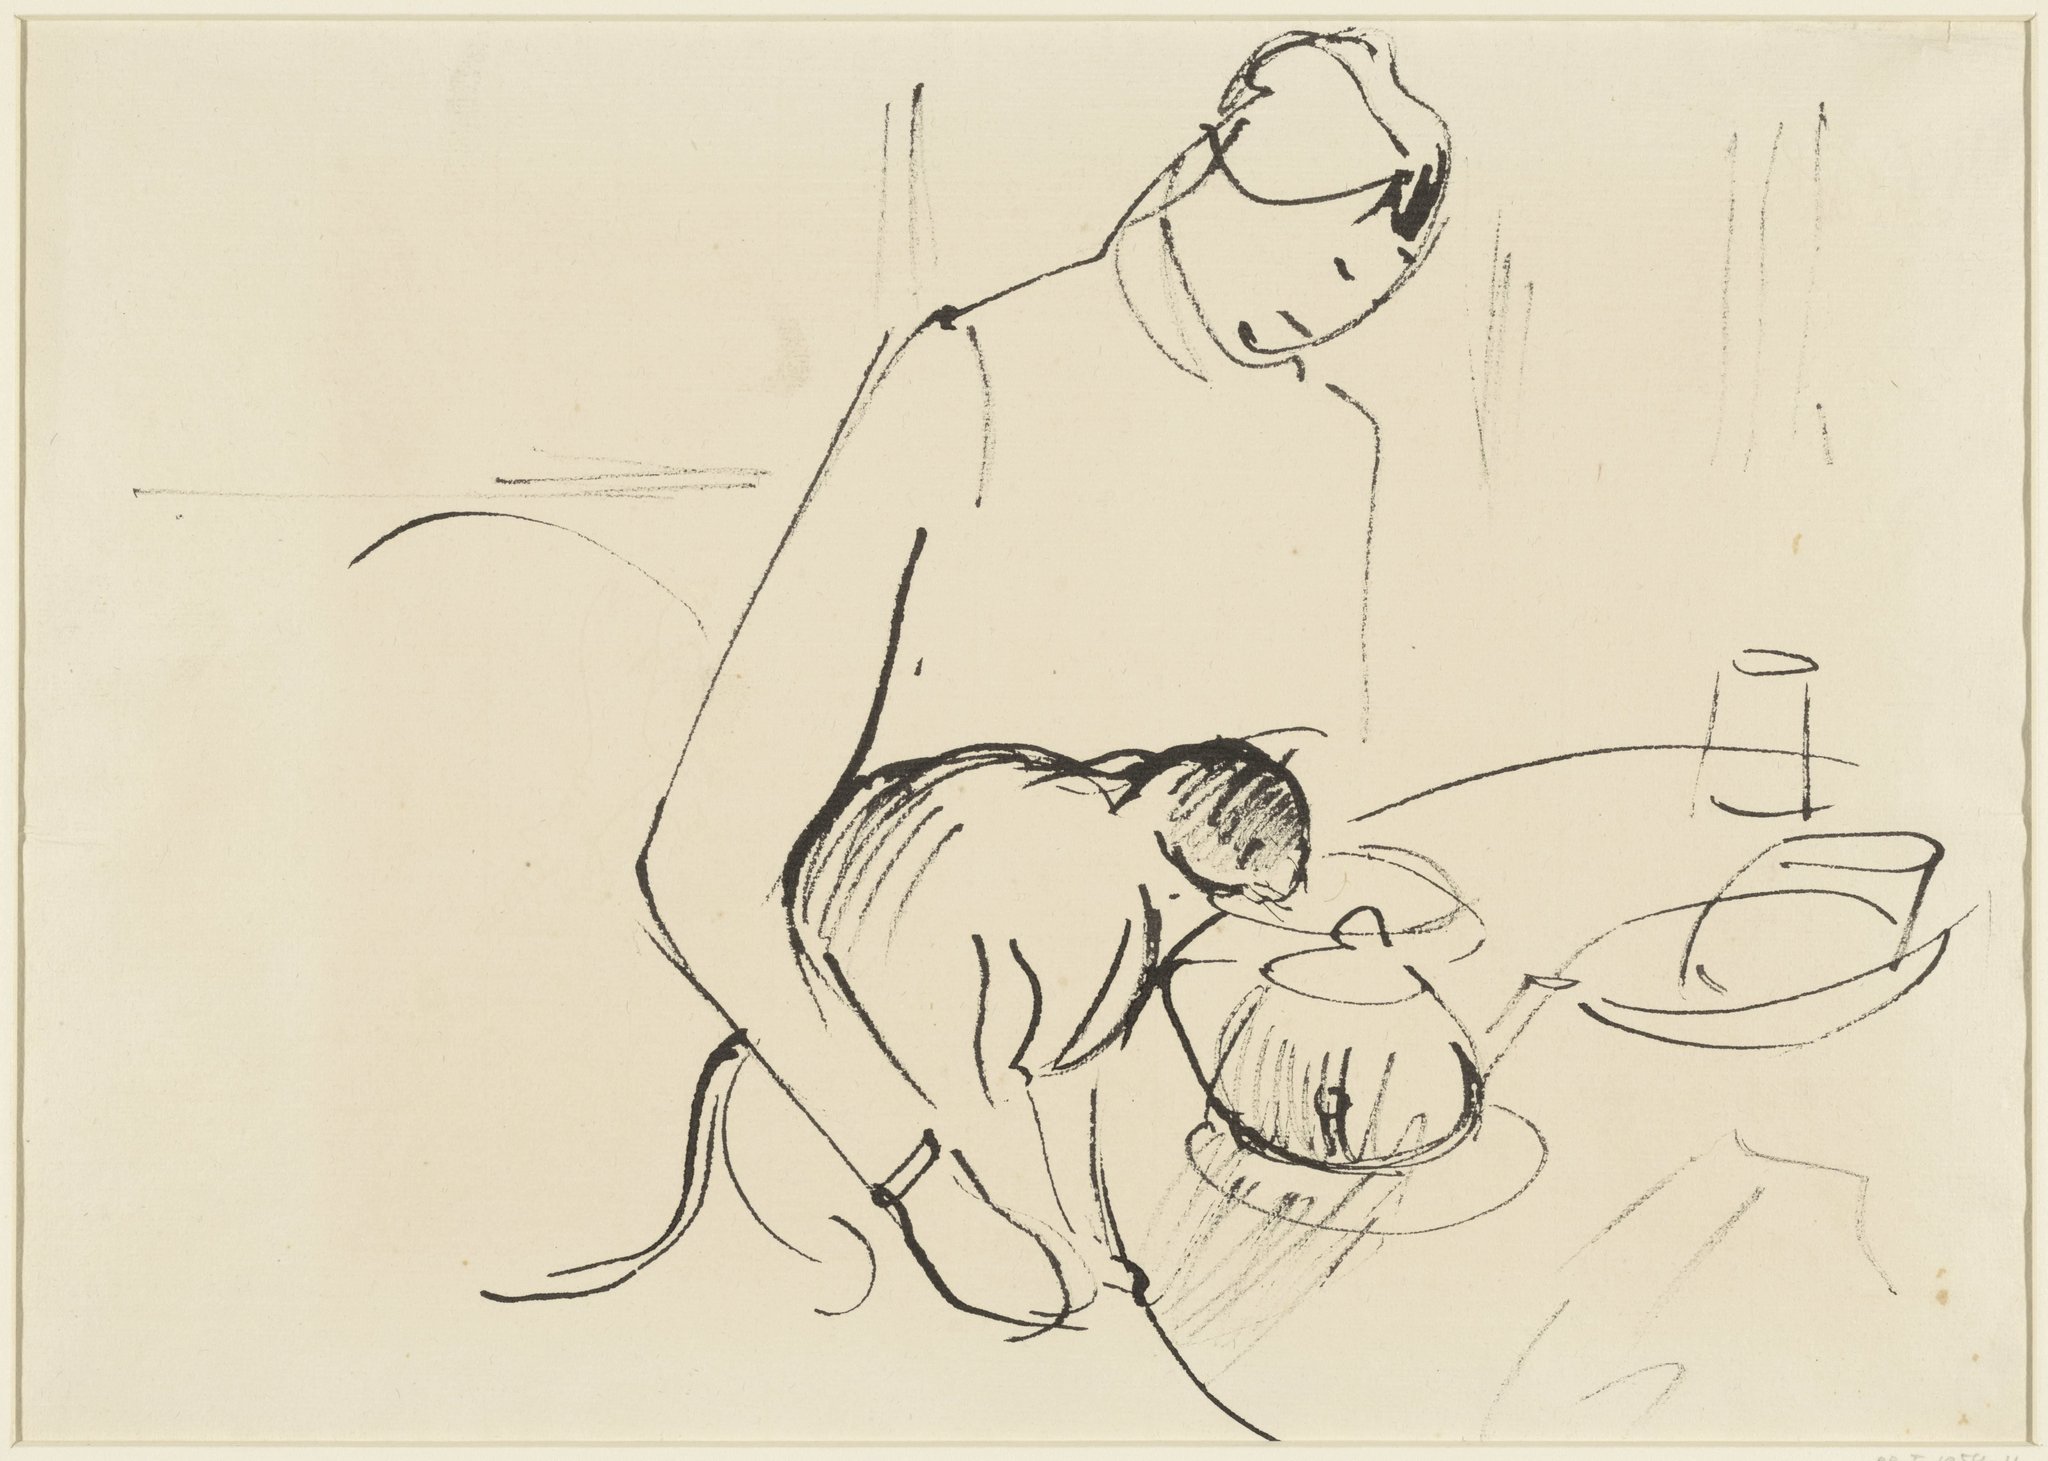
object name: drawing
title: Vrouw laat een kat drinken van een schoteltje op een gedekte tafel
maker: rik wouters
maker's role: draughtsman, print maker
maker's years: 1882-1916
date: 1892-1916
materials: ink, paper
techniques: pen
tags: cat, friendship between man and animal; caressing, petting